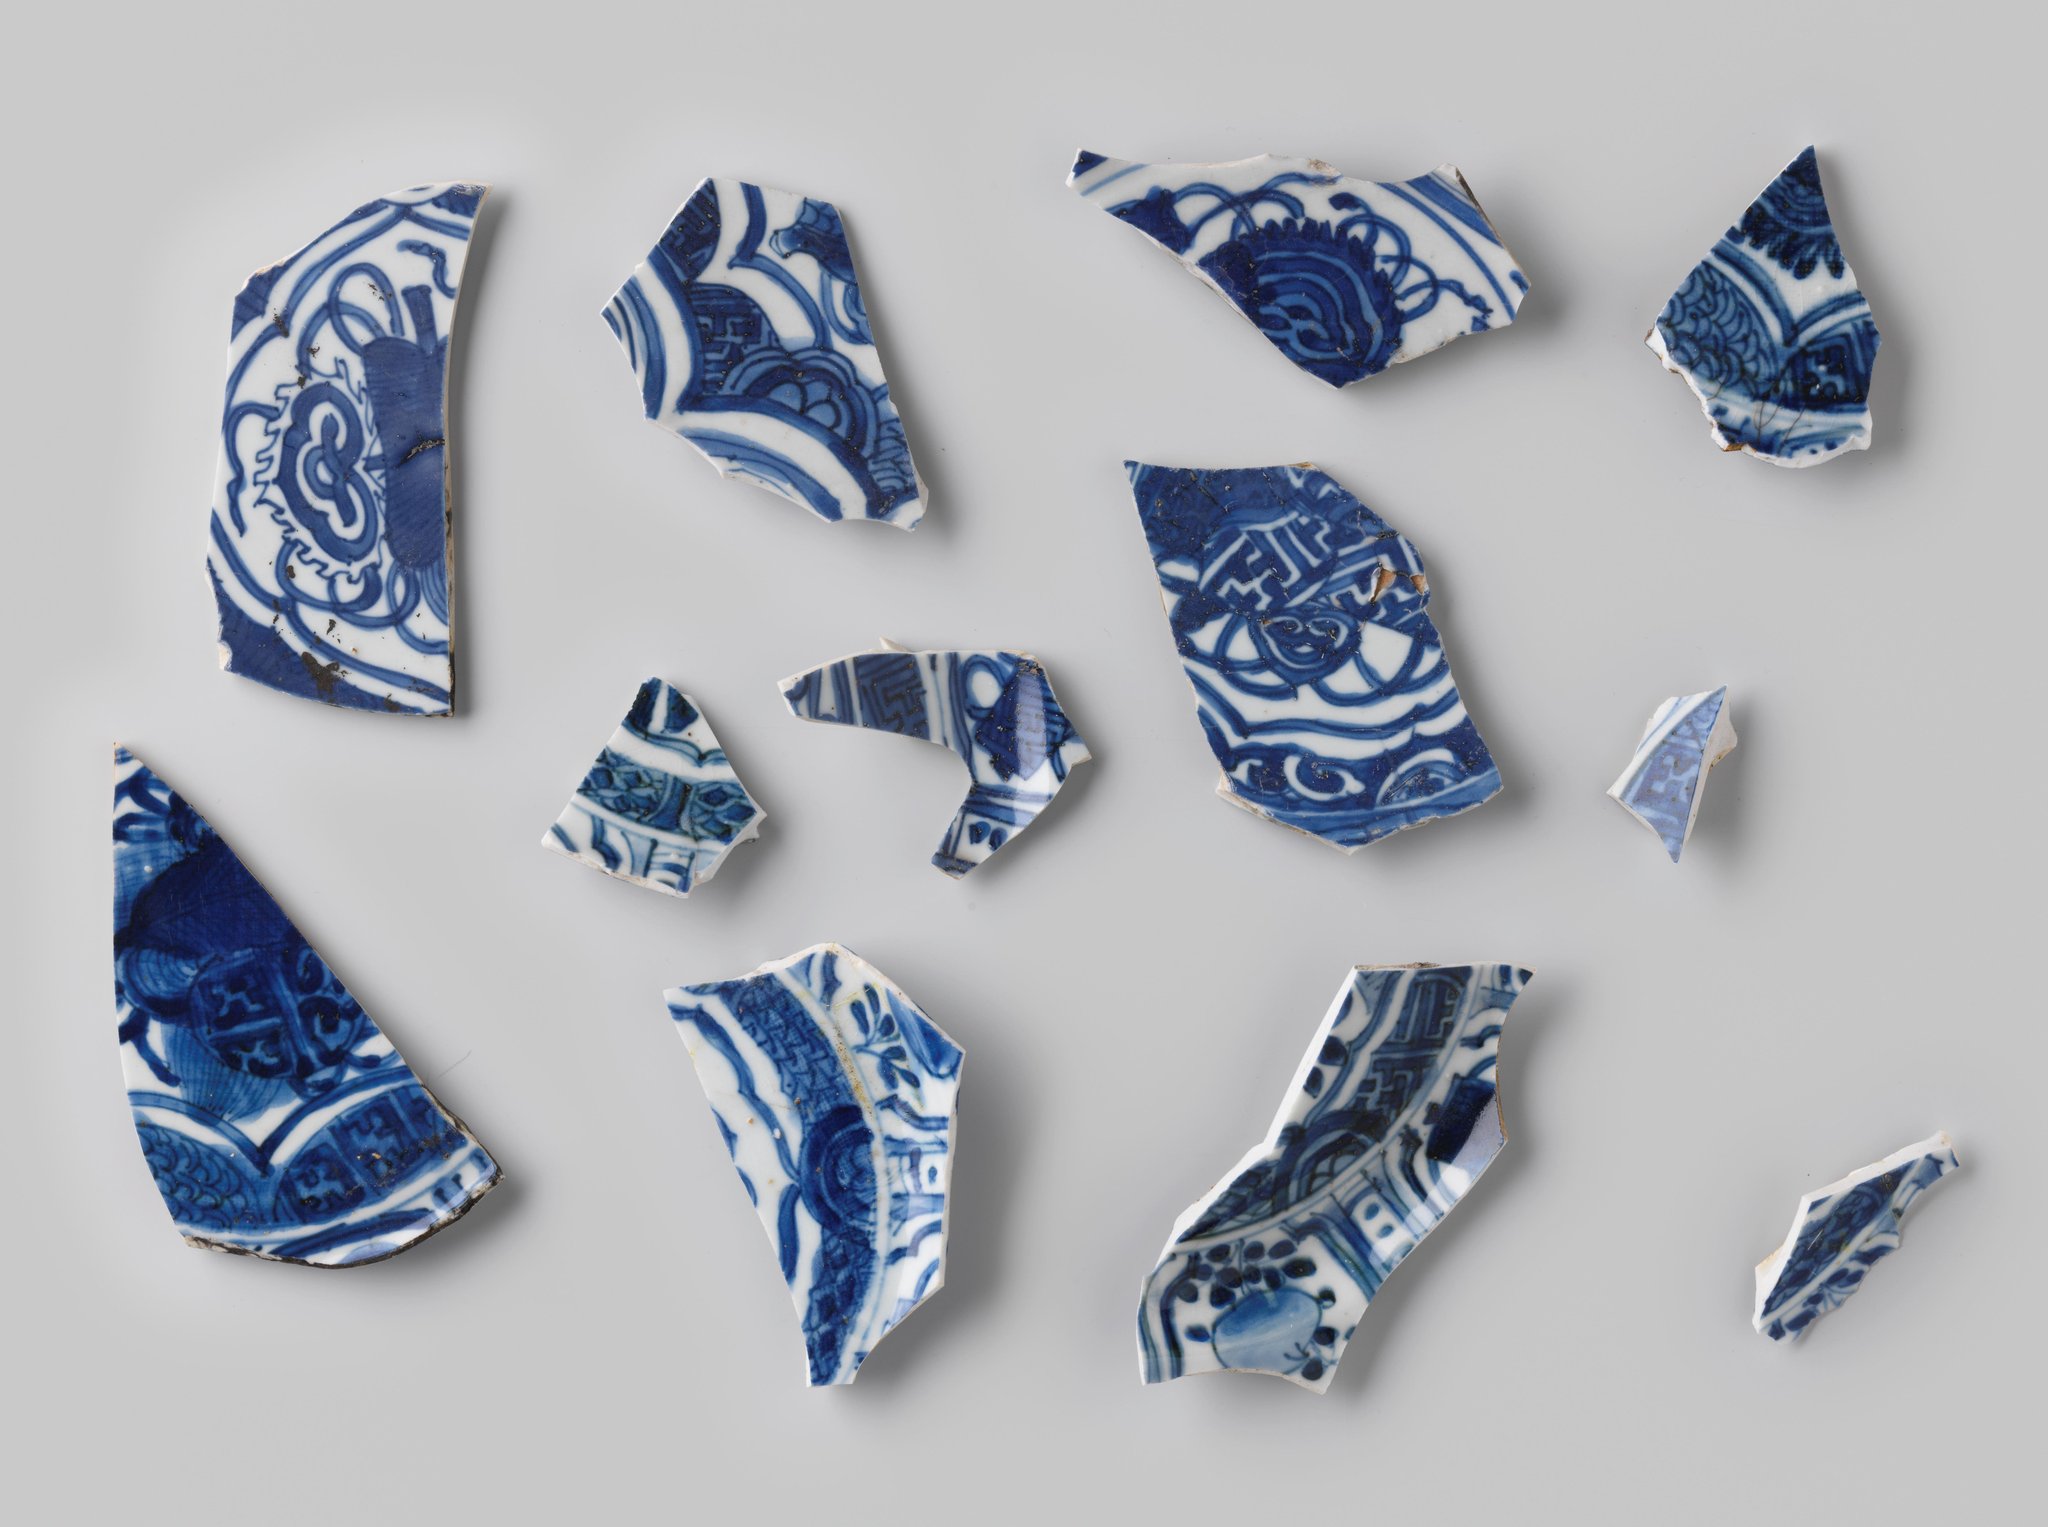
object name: sherd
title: Scherven van borden uit V.O.C.-schip de 'Witte Leeuw'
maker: Anonymous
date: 1613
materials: bone china, porcelain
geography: jingdezhen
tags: verenigde oostindische compagnie, sint-helena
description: A plate with a flattened rim. A four-sided scalloped medallion with 4 rui heads and various diaper patterns. A central decoration of symbols. Panels decorated with flowers and symbols.